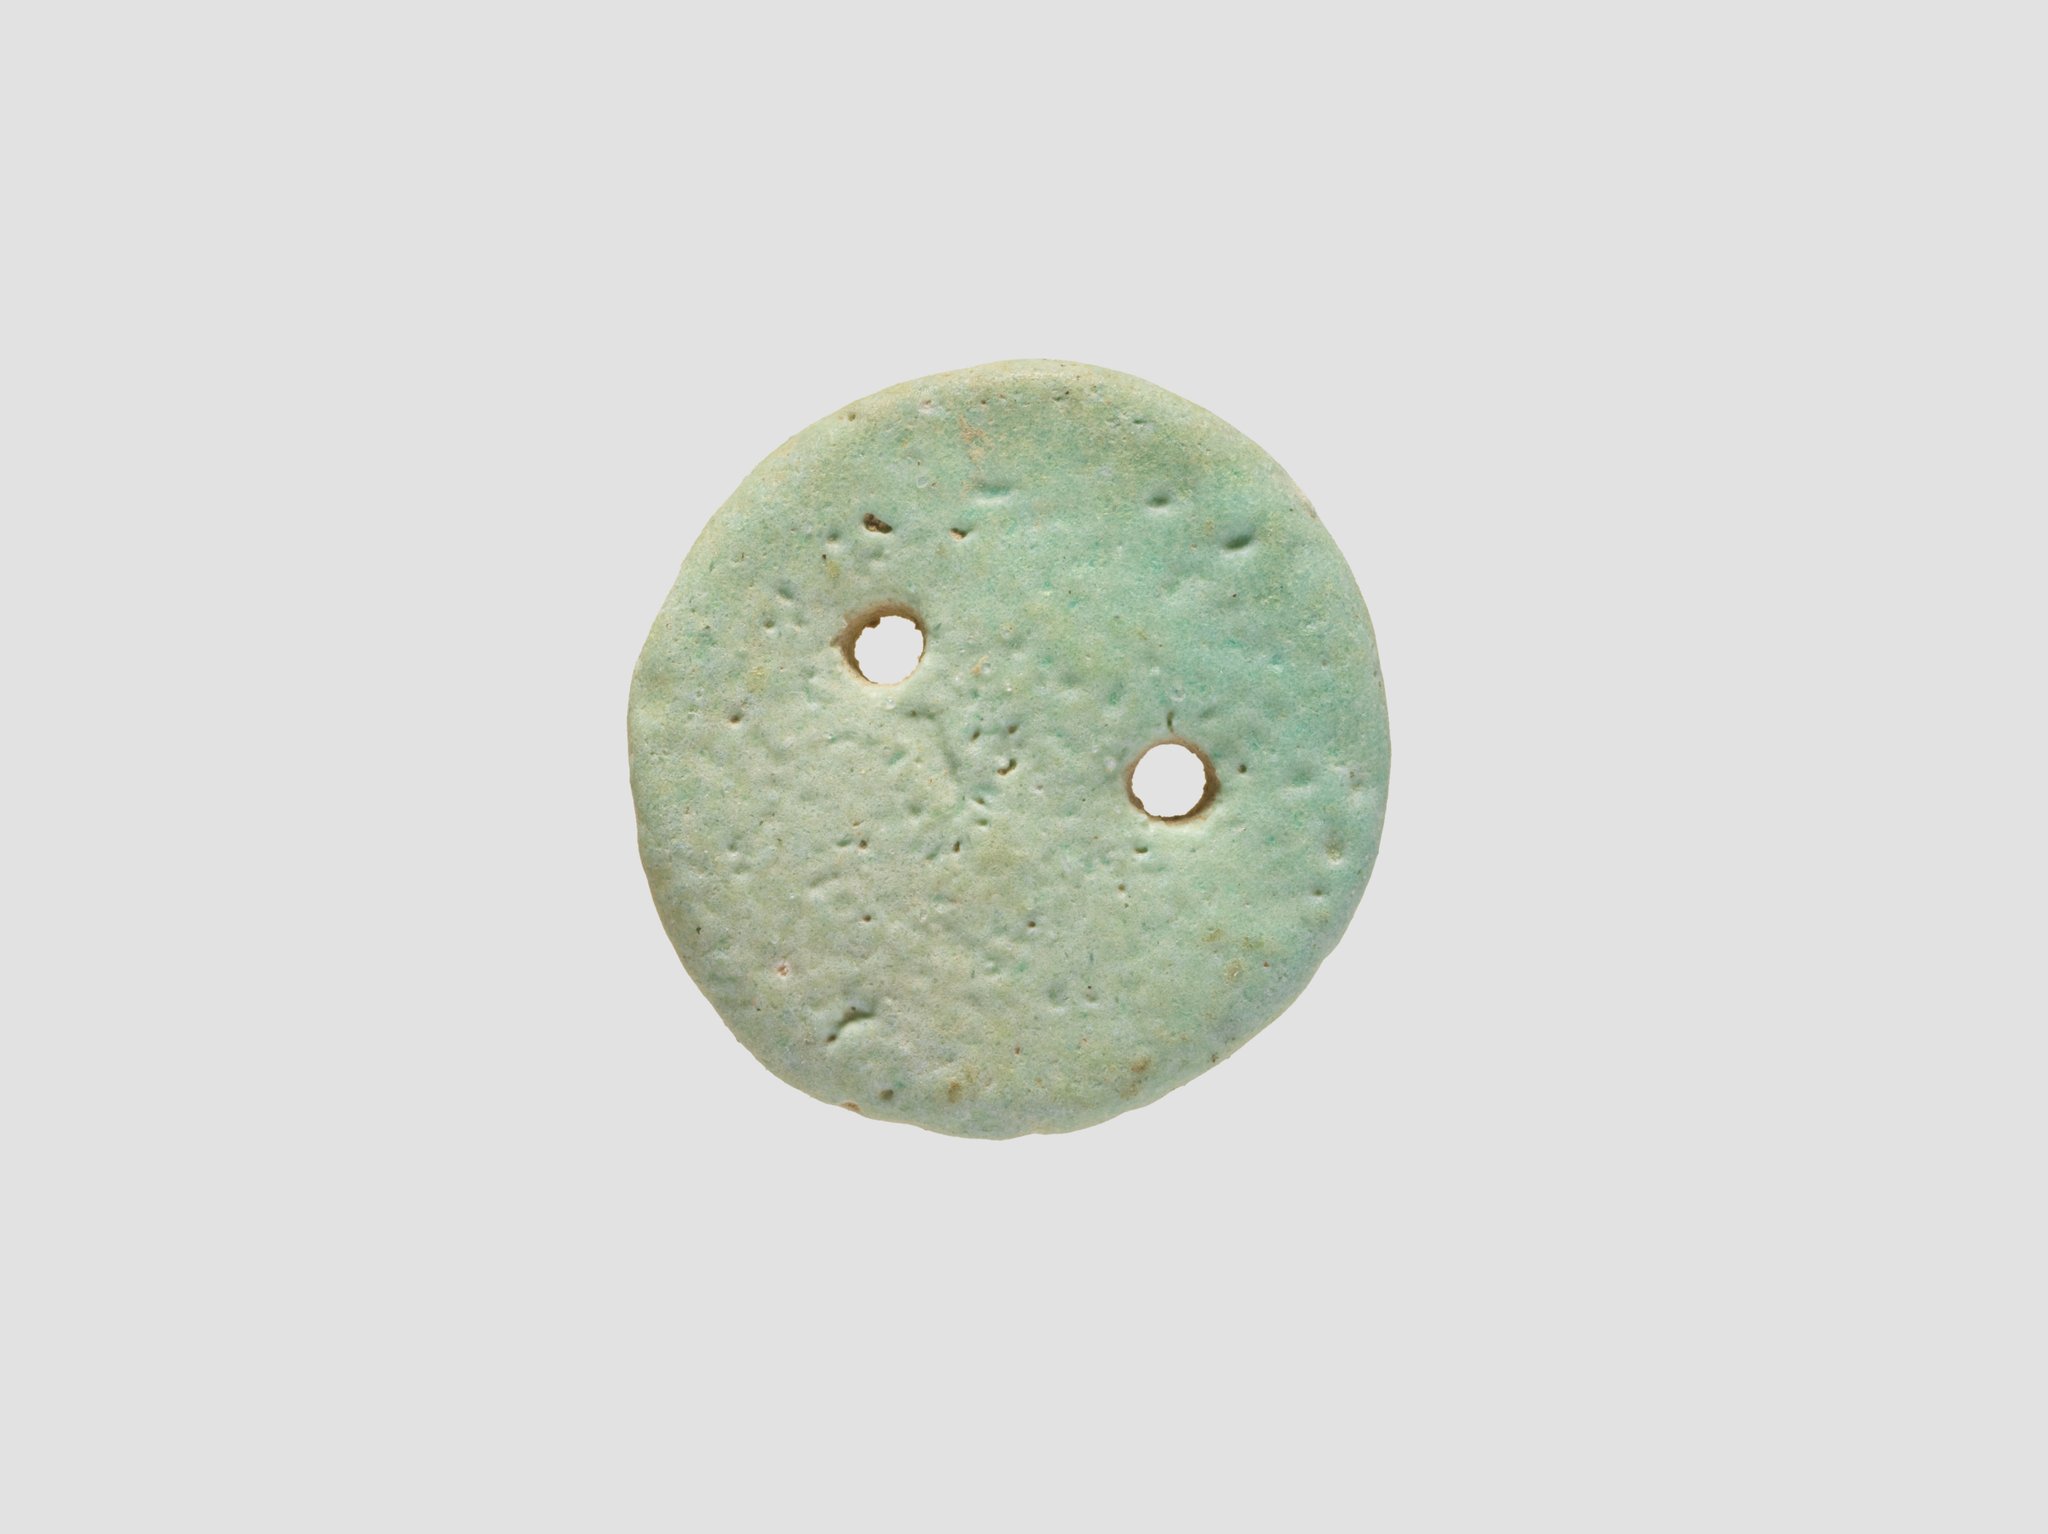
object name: ornament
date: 2333-2001 BCE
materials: faience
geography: mesopotamia